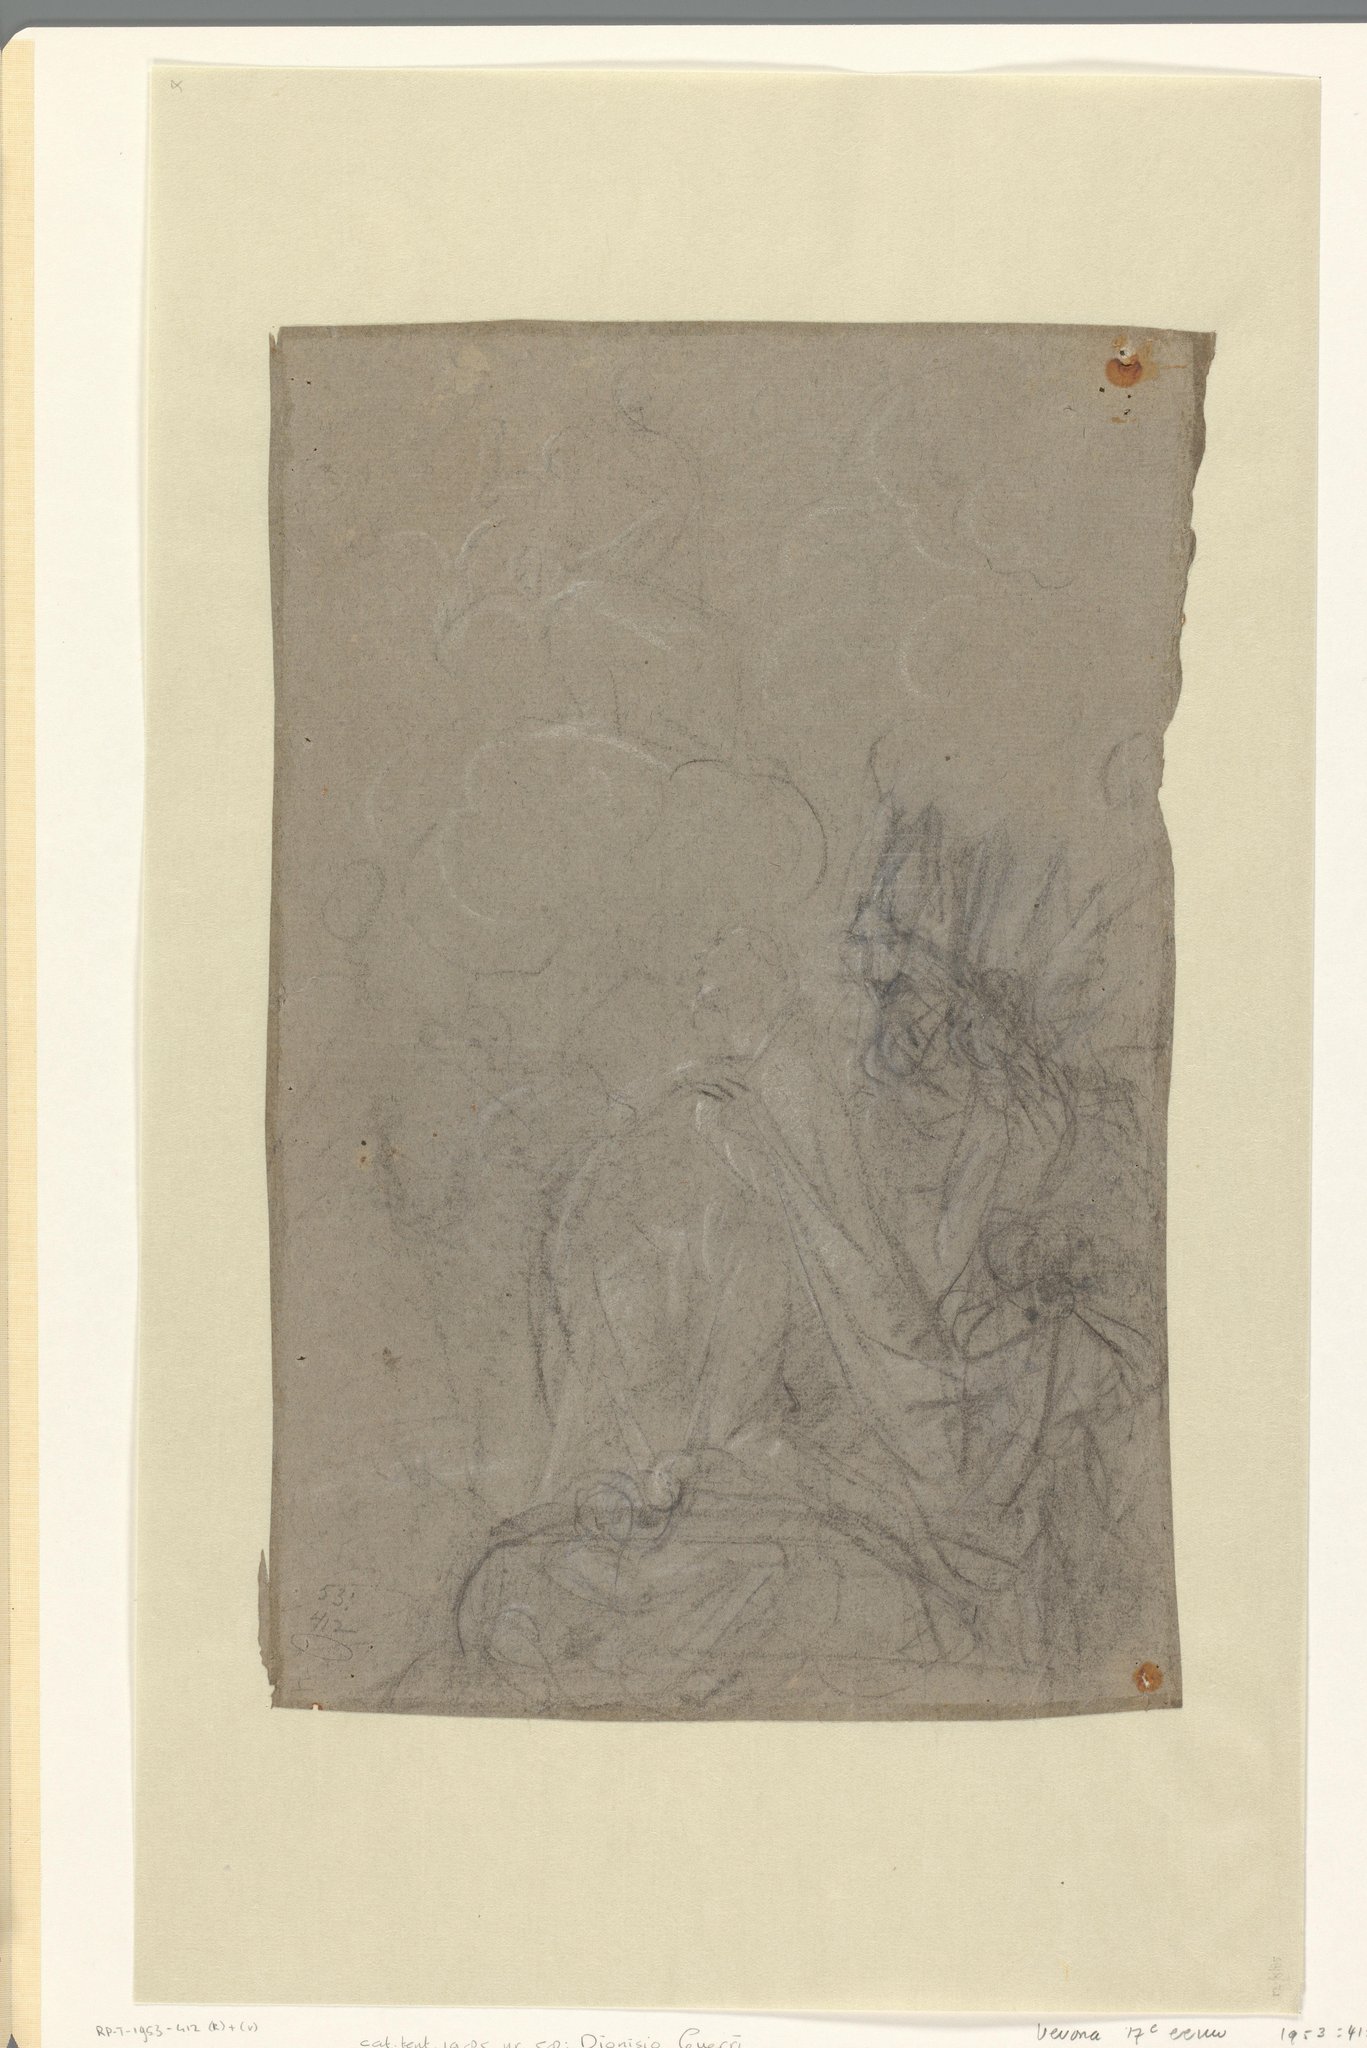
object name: drawing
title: Schetsbladen met figuurstudies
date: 1600-1699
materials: chalk, paper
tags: kneeling figure